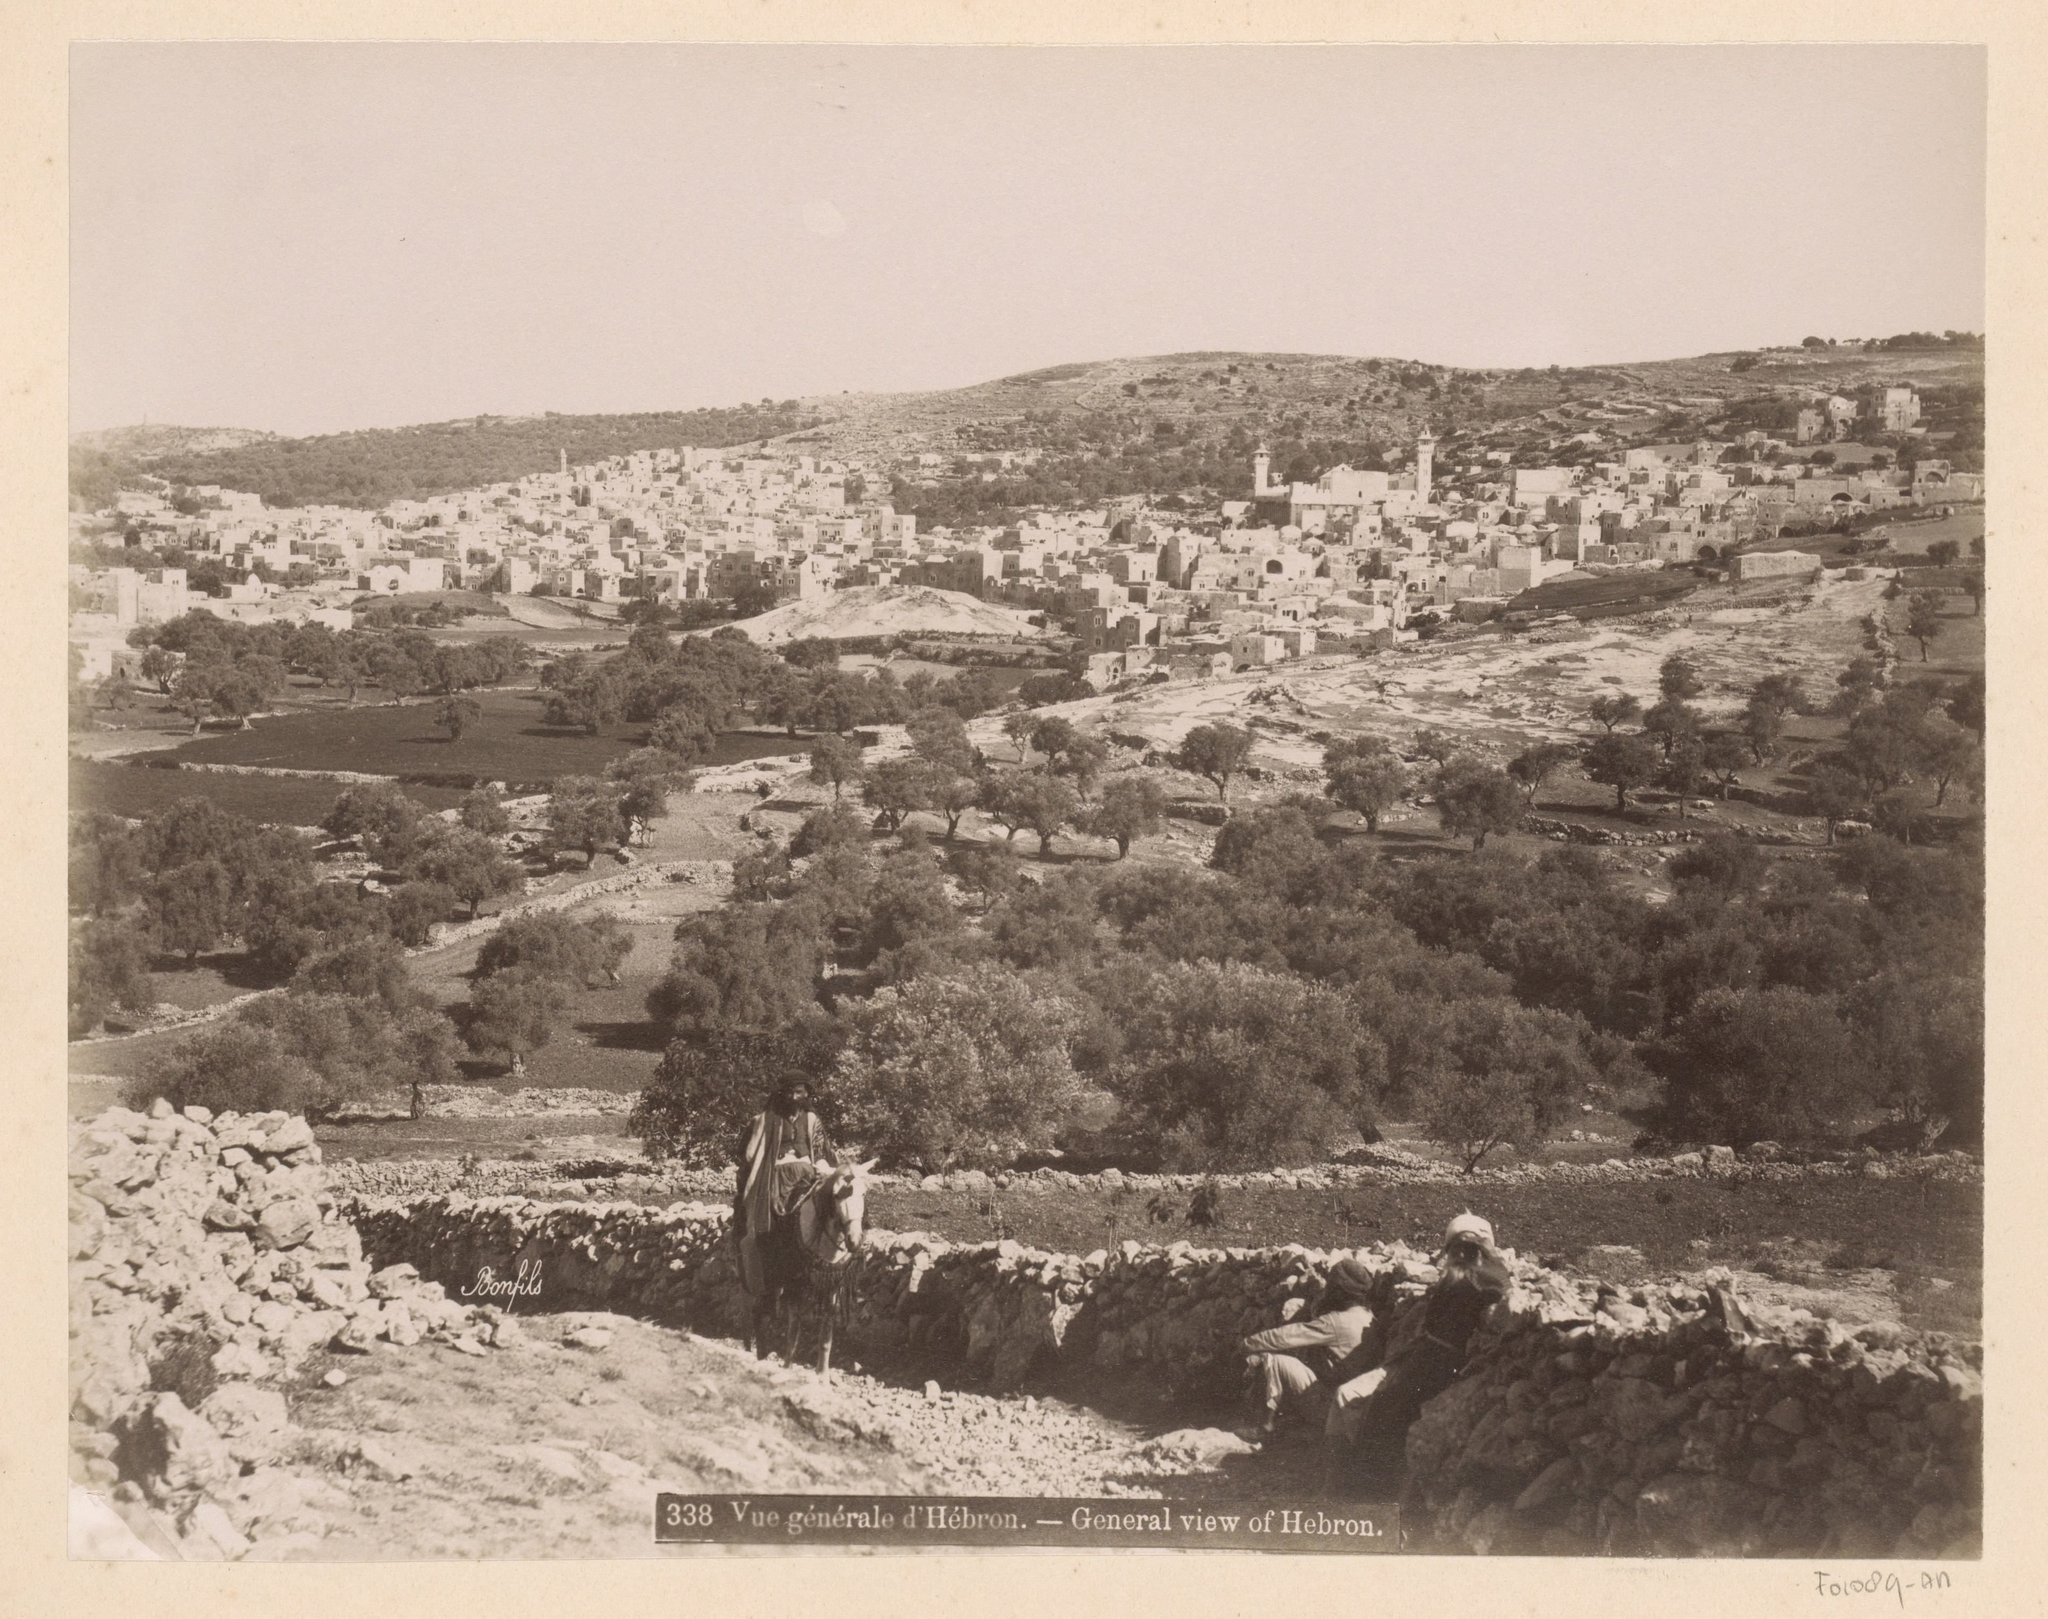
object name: photograph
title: Vue générale d'Hebron.- General view of Hebron.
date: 1867-1895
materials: cardboard, paper, photographic support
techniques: albumen print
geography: hebron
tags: prospect of city, town panorama, silhouette of city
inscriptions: negative number: ‘338’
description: Onderdeel van Reisalbum met foto's van Jeruzalem en andere bijbelse plaatsen.